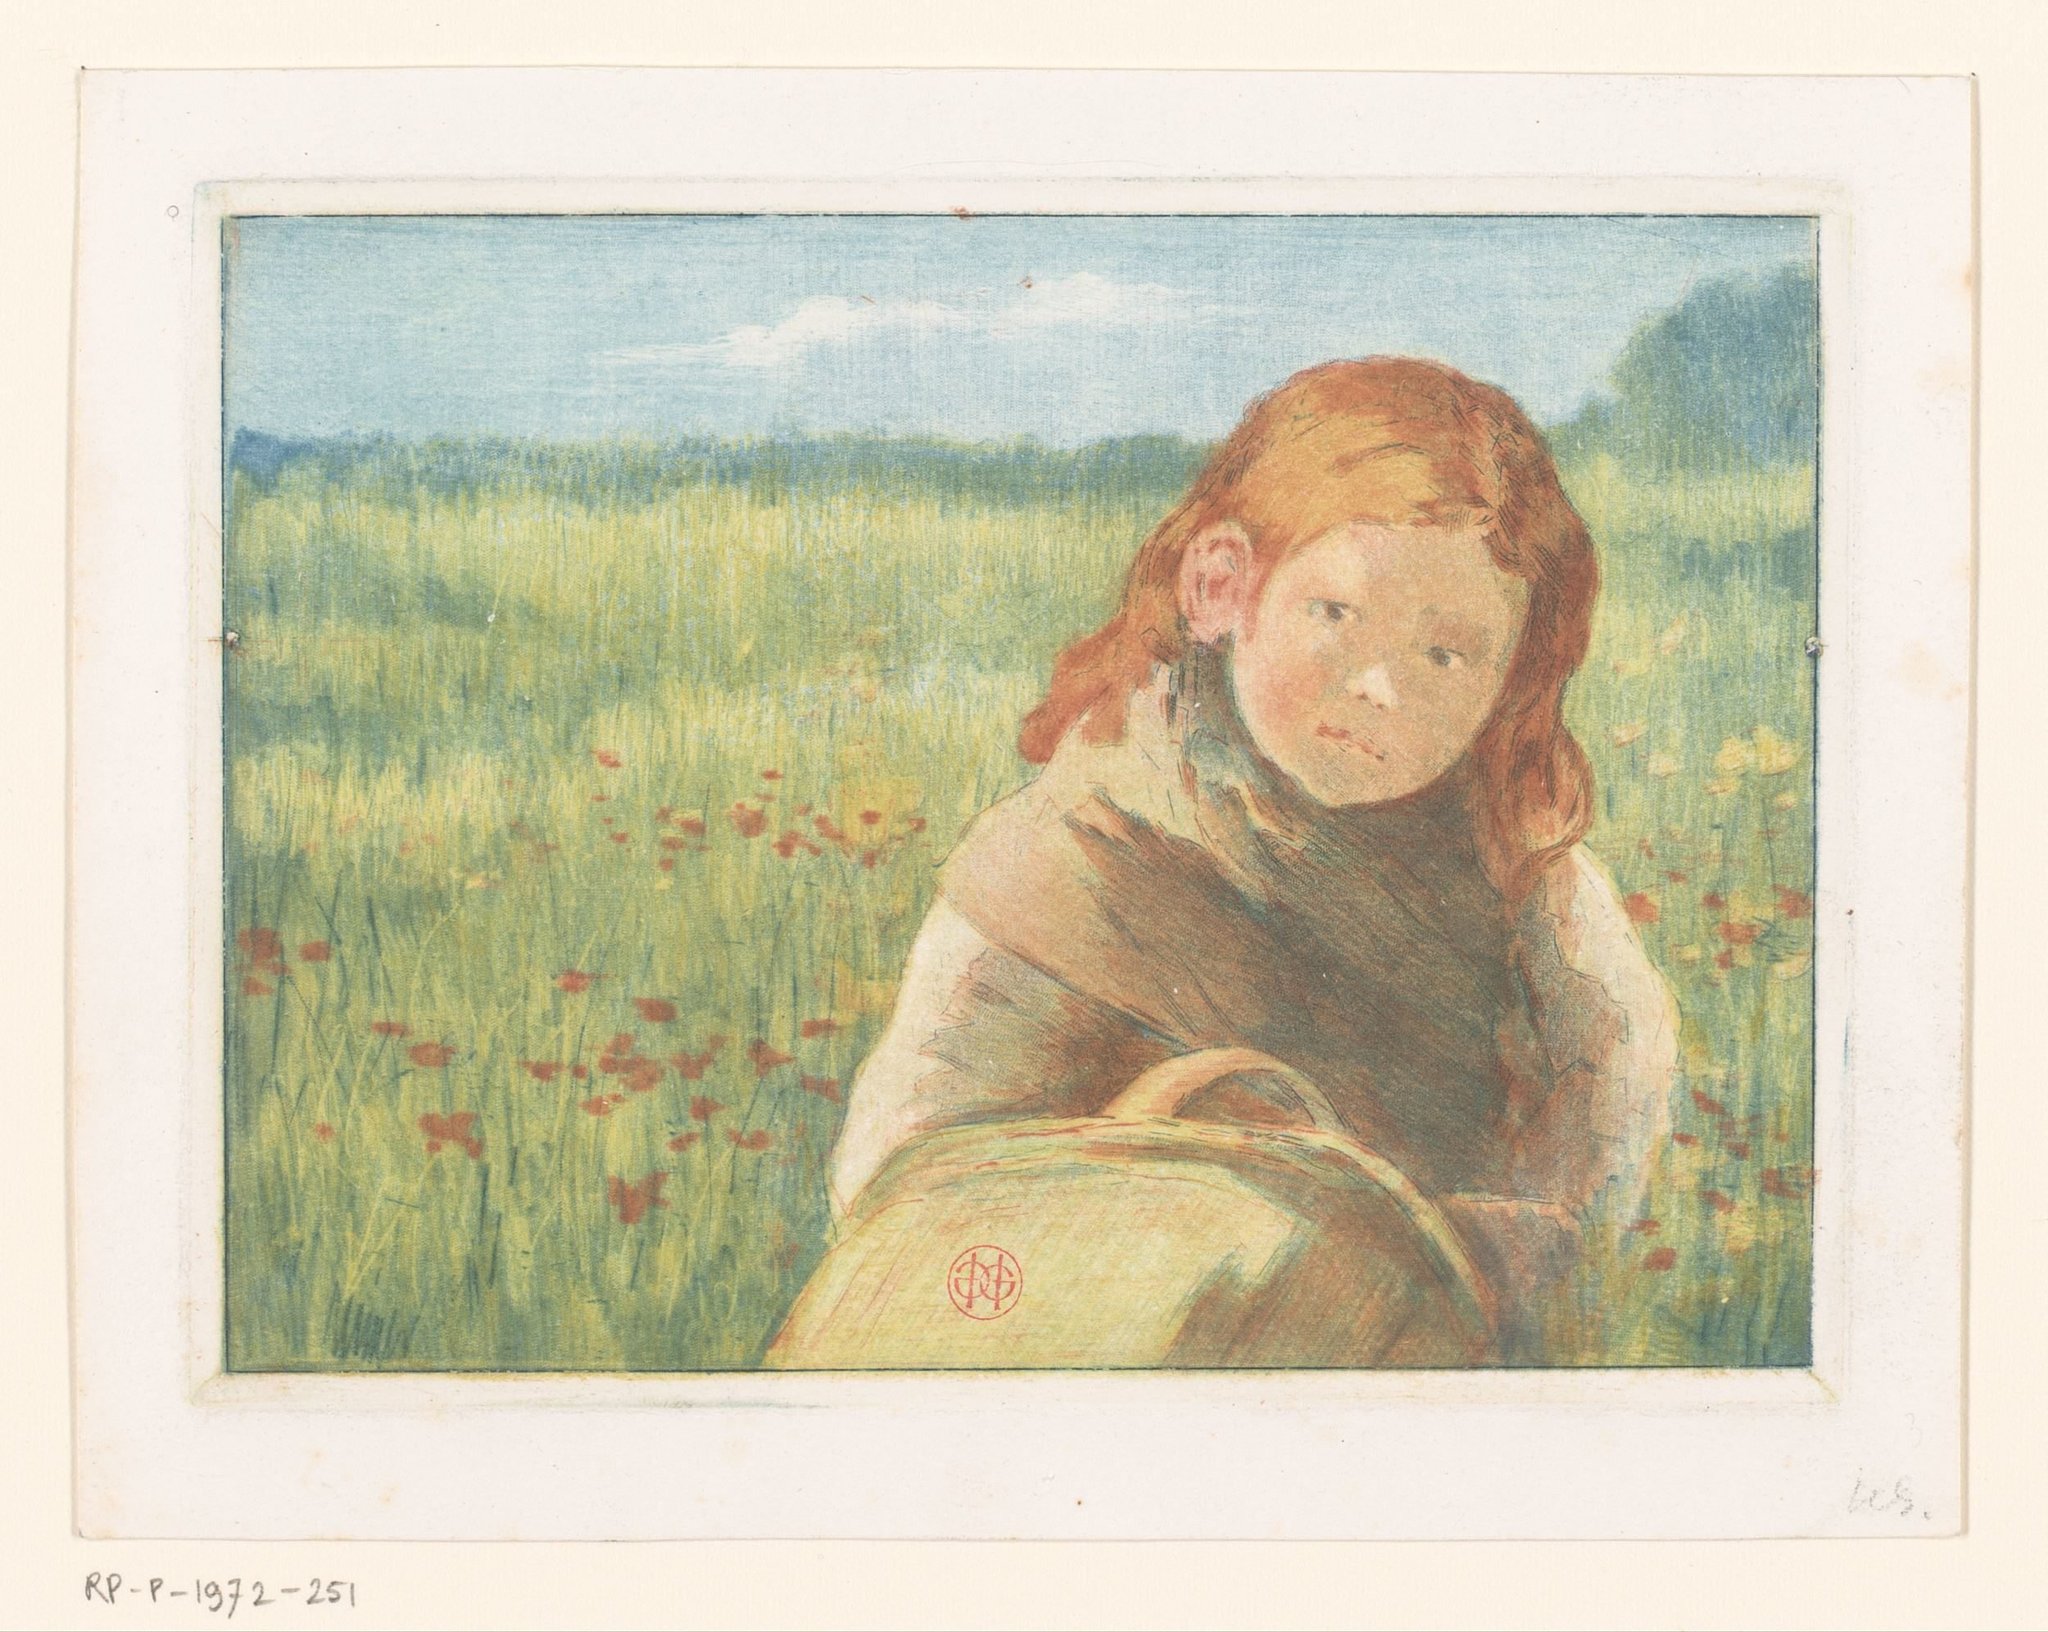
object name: print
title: Meisje met mand in een bloemenweide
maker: henri charles guérard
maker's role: print maker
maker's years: 1846-1897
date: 1856-1897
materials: paper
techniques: roulette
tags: meadow, pasture, container made of plant material other than wood: basket, girl (child between toddler and youth)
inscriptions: collector's mark: Lugt 2228, collector's mark: Lugt 2760, stamp: Lugt 1157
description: Het Rijksmuseum beschikt over negentien drukken van dezelfde voorstelling (RP-P-1972-234 t/m RP-P-1972-252) in verschillende staten en tonen.